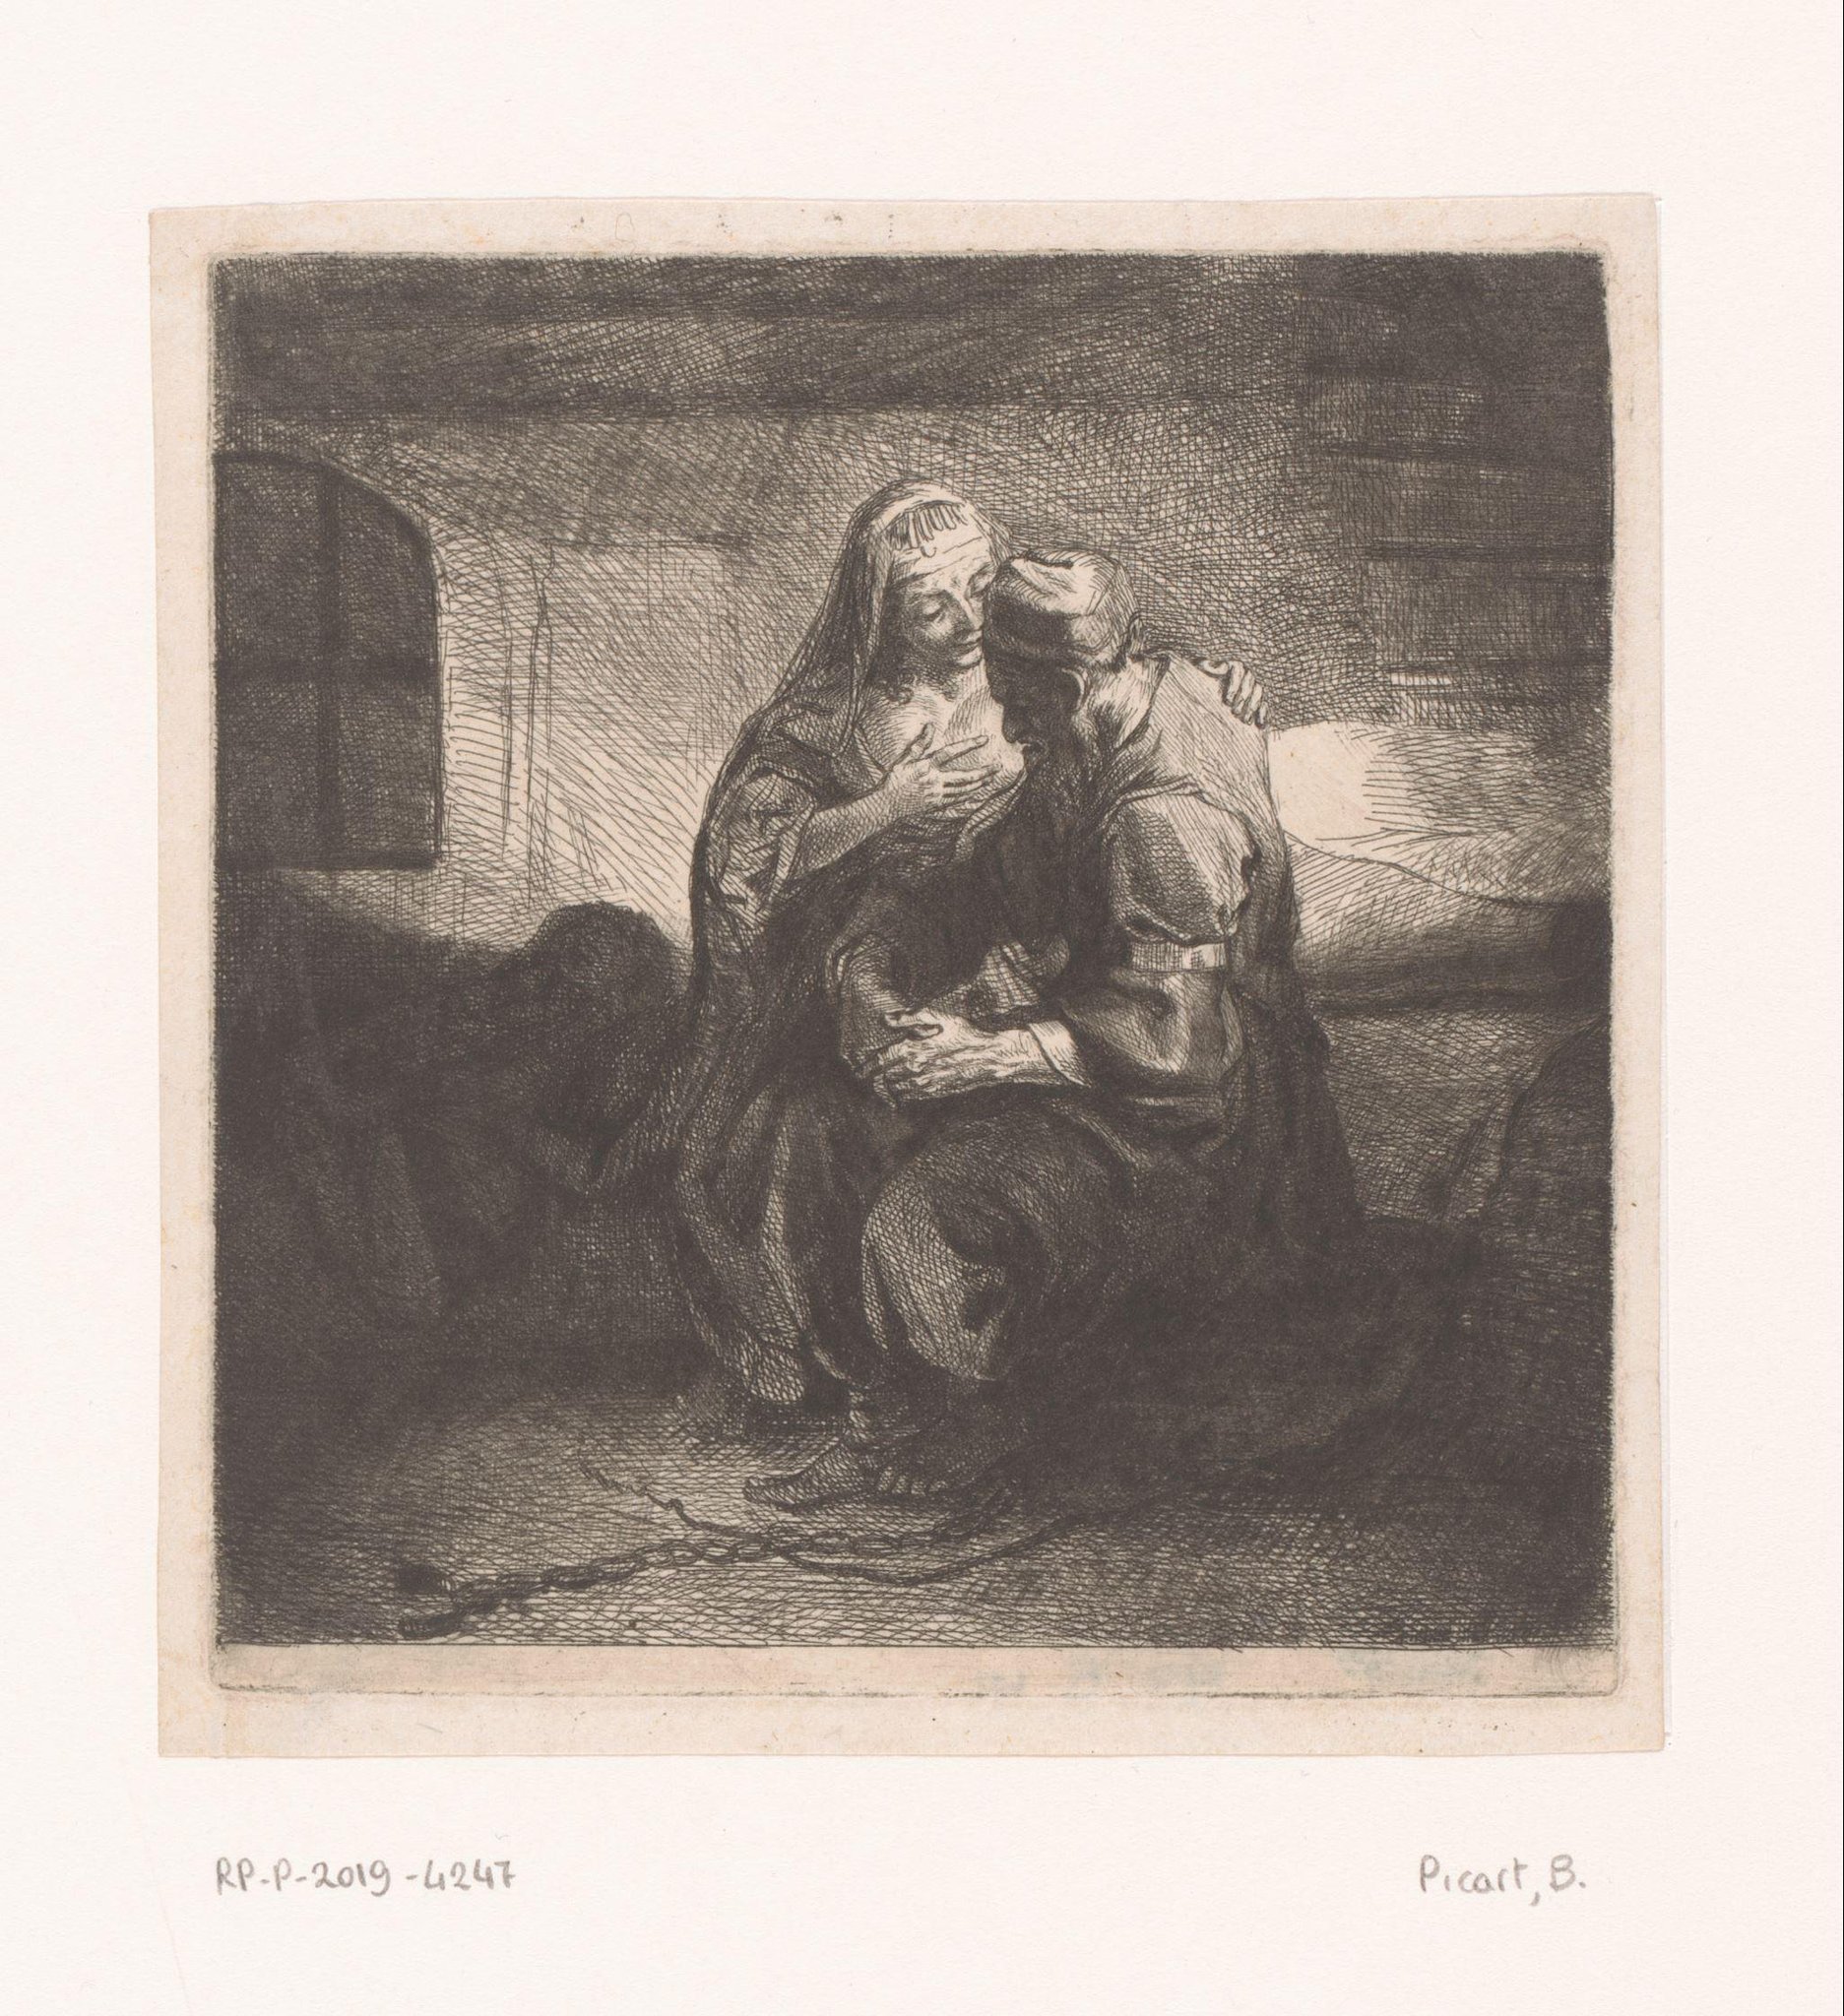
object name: print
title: Impostures Innocentes, Ou Recueil D'Estampes D'Apres Divers Peintres Illustres (...)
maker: bernard picart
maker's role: draughtsman, print maker, publisher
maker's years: 1673-1733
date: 1723-1733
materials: paper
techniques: etching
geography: amsterdam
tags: pero suckling cimon ('caritas romana')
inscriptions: collector's mark: Lugt 2165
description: De prent werd na het overlijden van Picart door zijn weduwe uitgegeven in een gebundelde prentenserie: Picart, Bernard. Impostures Innocentes, Ou Recueil D'Estampes D'Apres Divers Peintres Illustres (...). Amsterdam: weduwe Bernard Picart, 1734.